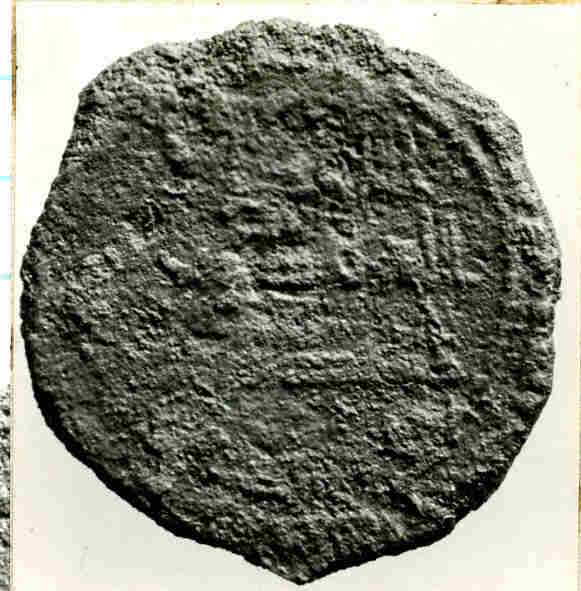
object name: coin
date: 701-900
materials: copper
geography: iran